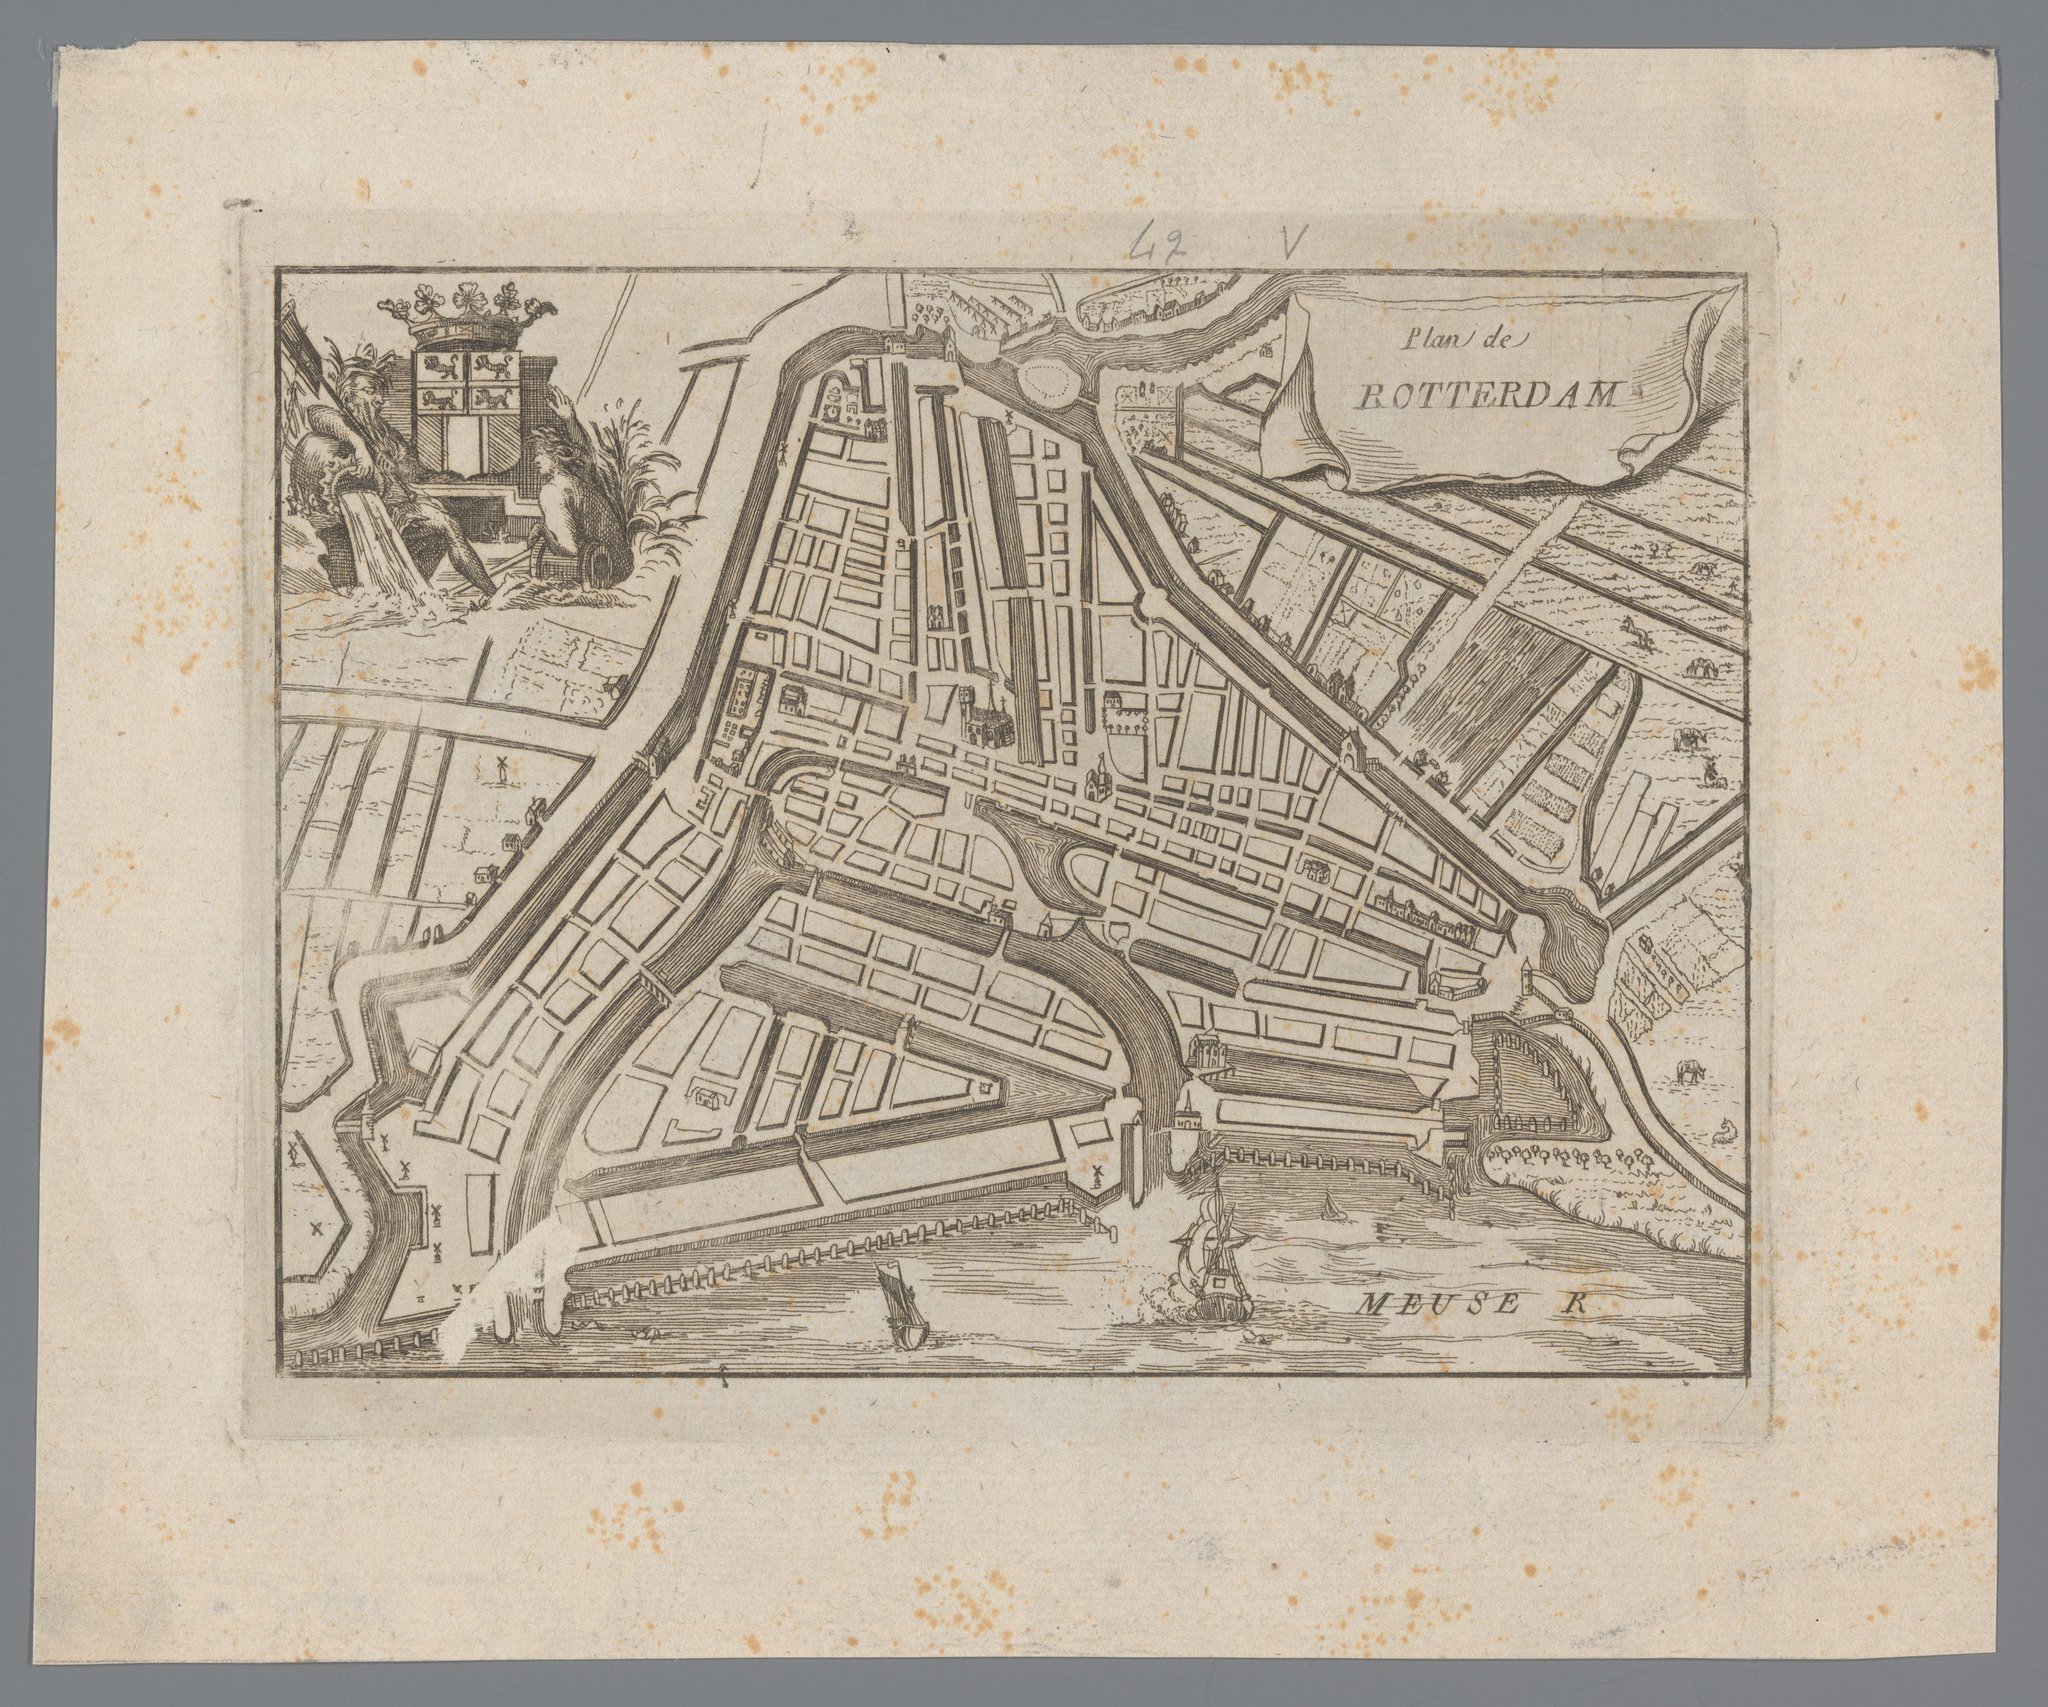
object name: area plan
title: Plattegrond van Rotterdam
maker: Anonymous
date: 1650-1700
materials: paper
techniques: engraving, etching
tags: maps of cities, rotterdam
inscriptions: collector's mark: Lugt 2228